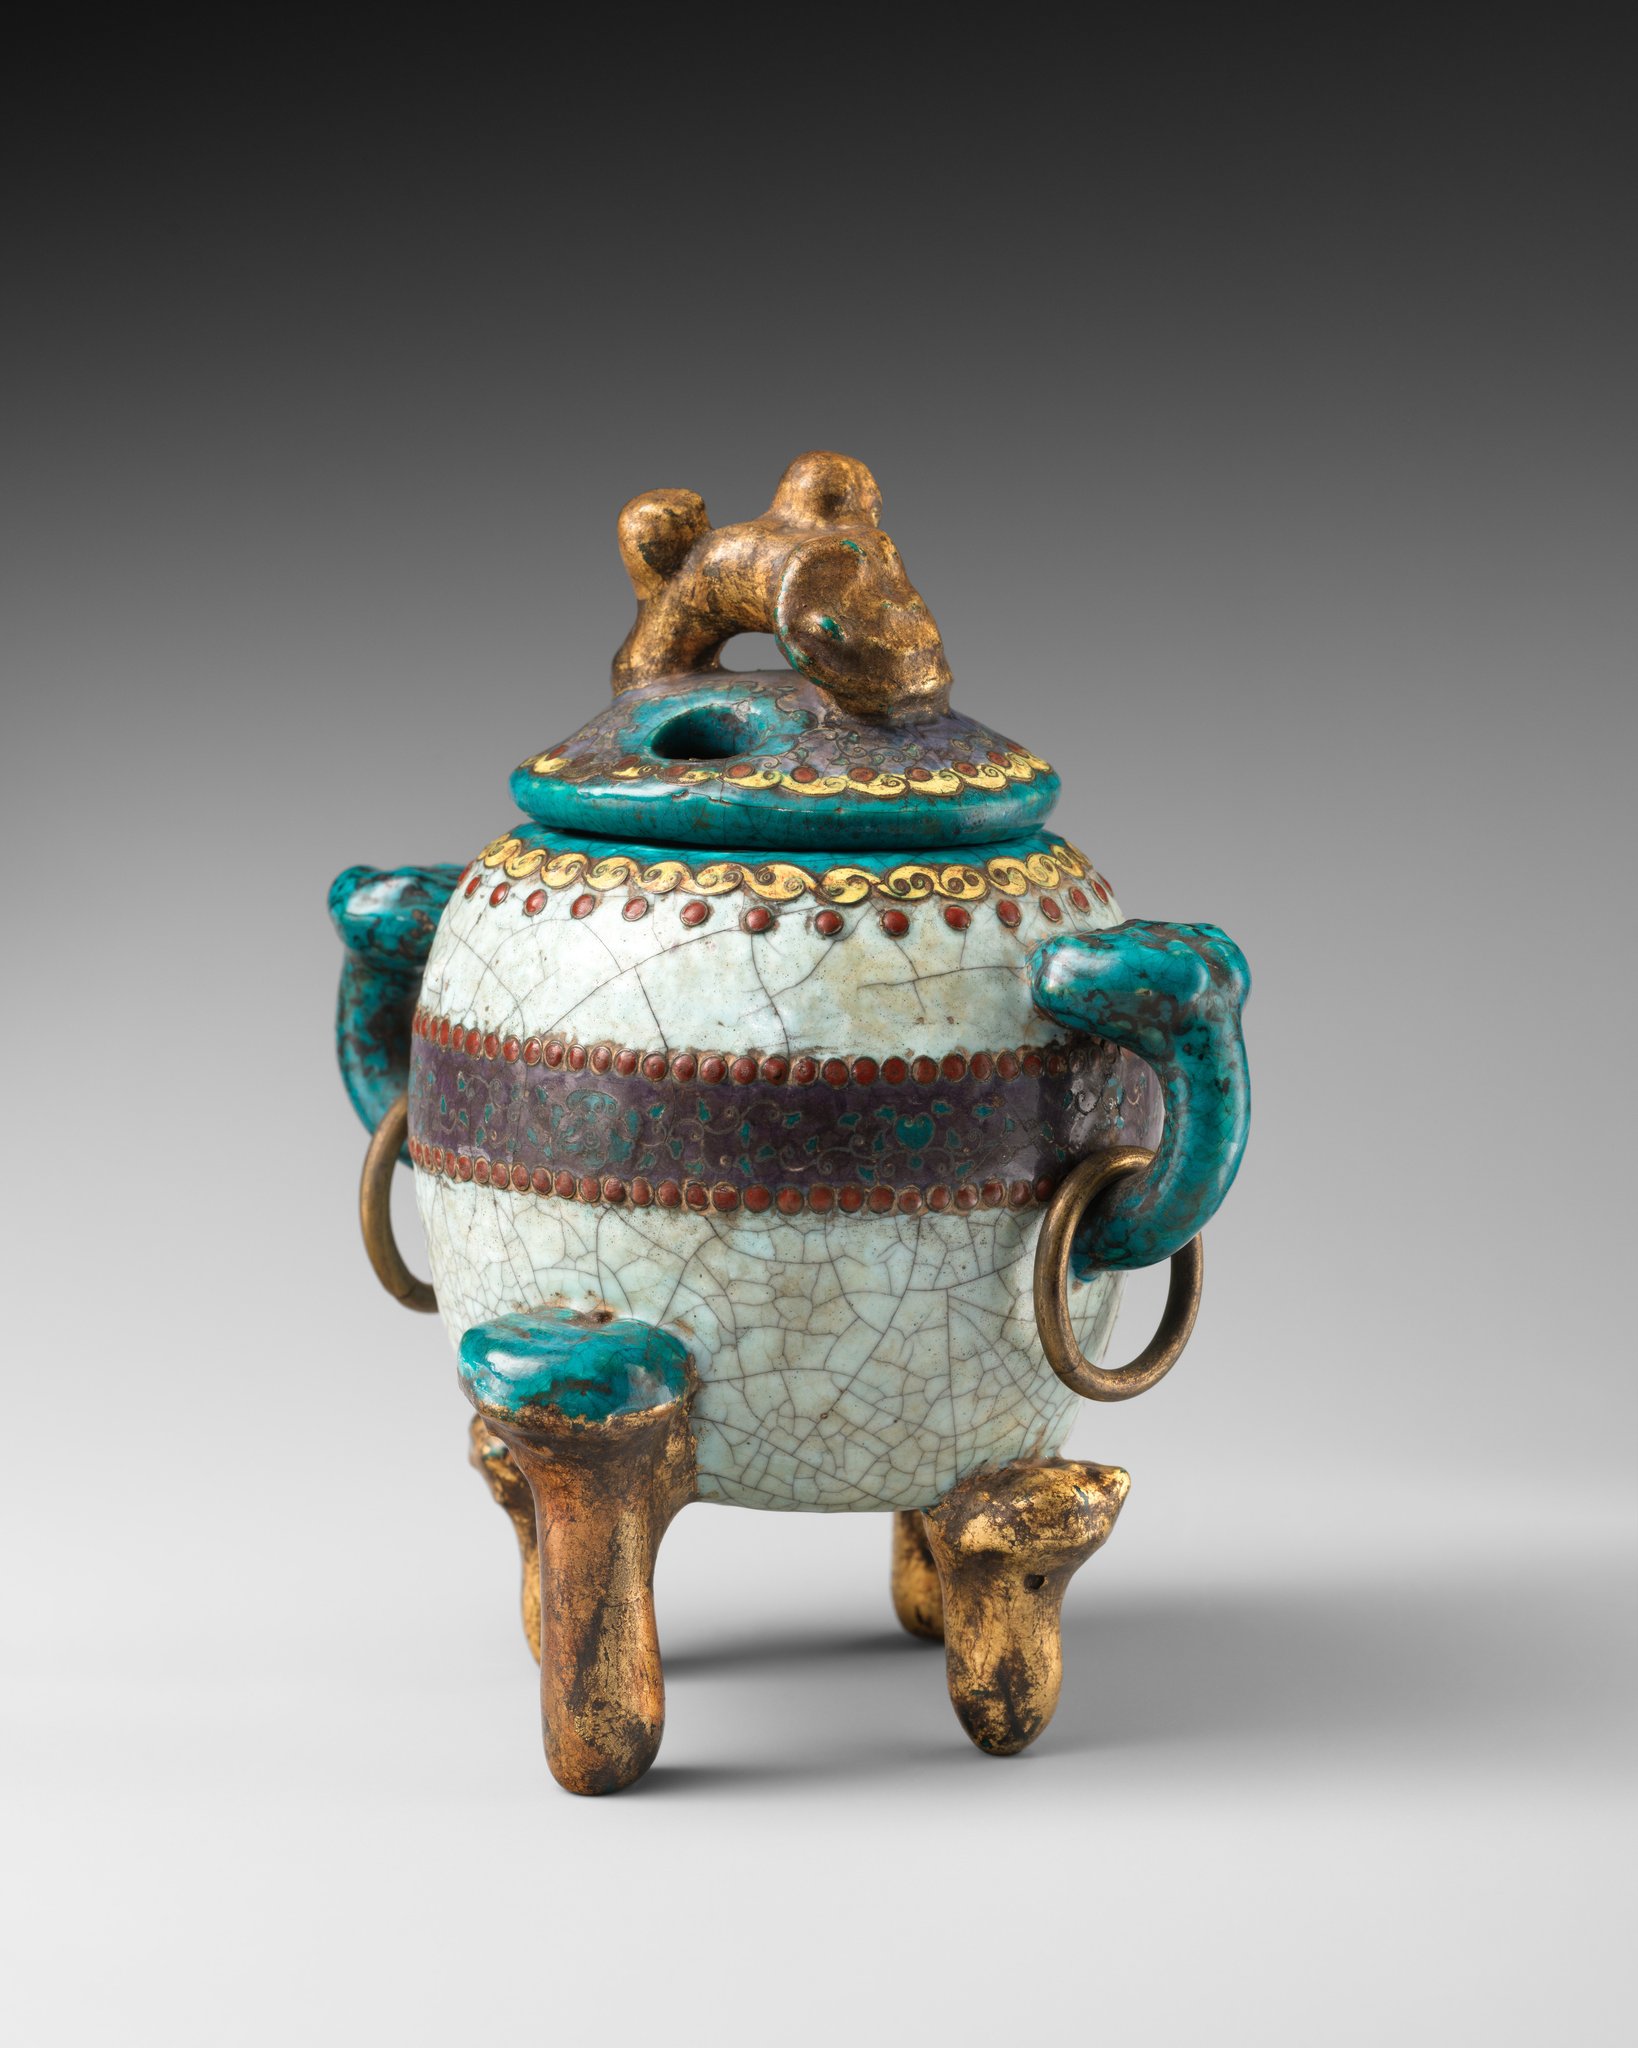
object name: incense burner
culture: japanese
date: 1701-1800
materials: bronze, glaze, pottery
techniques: enamel